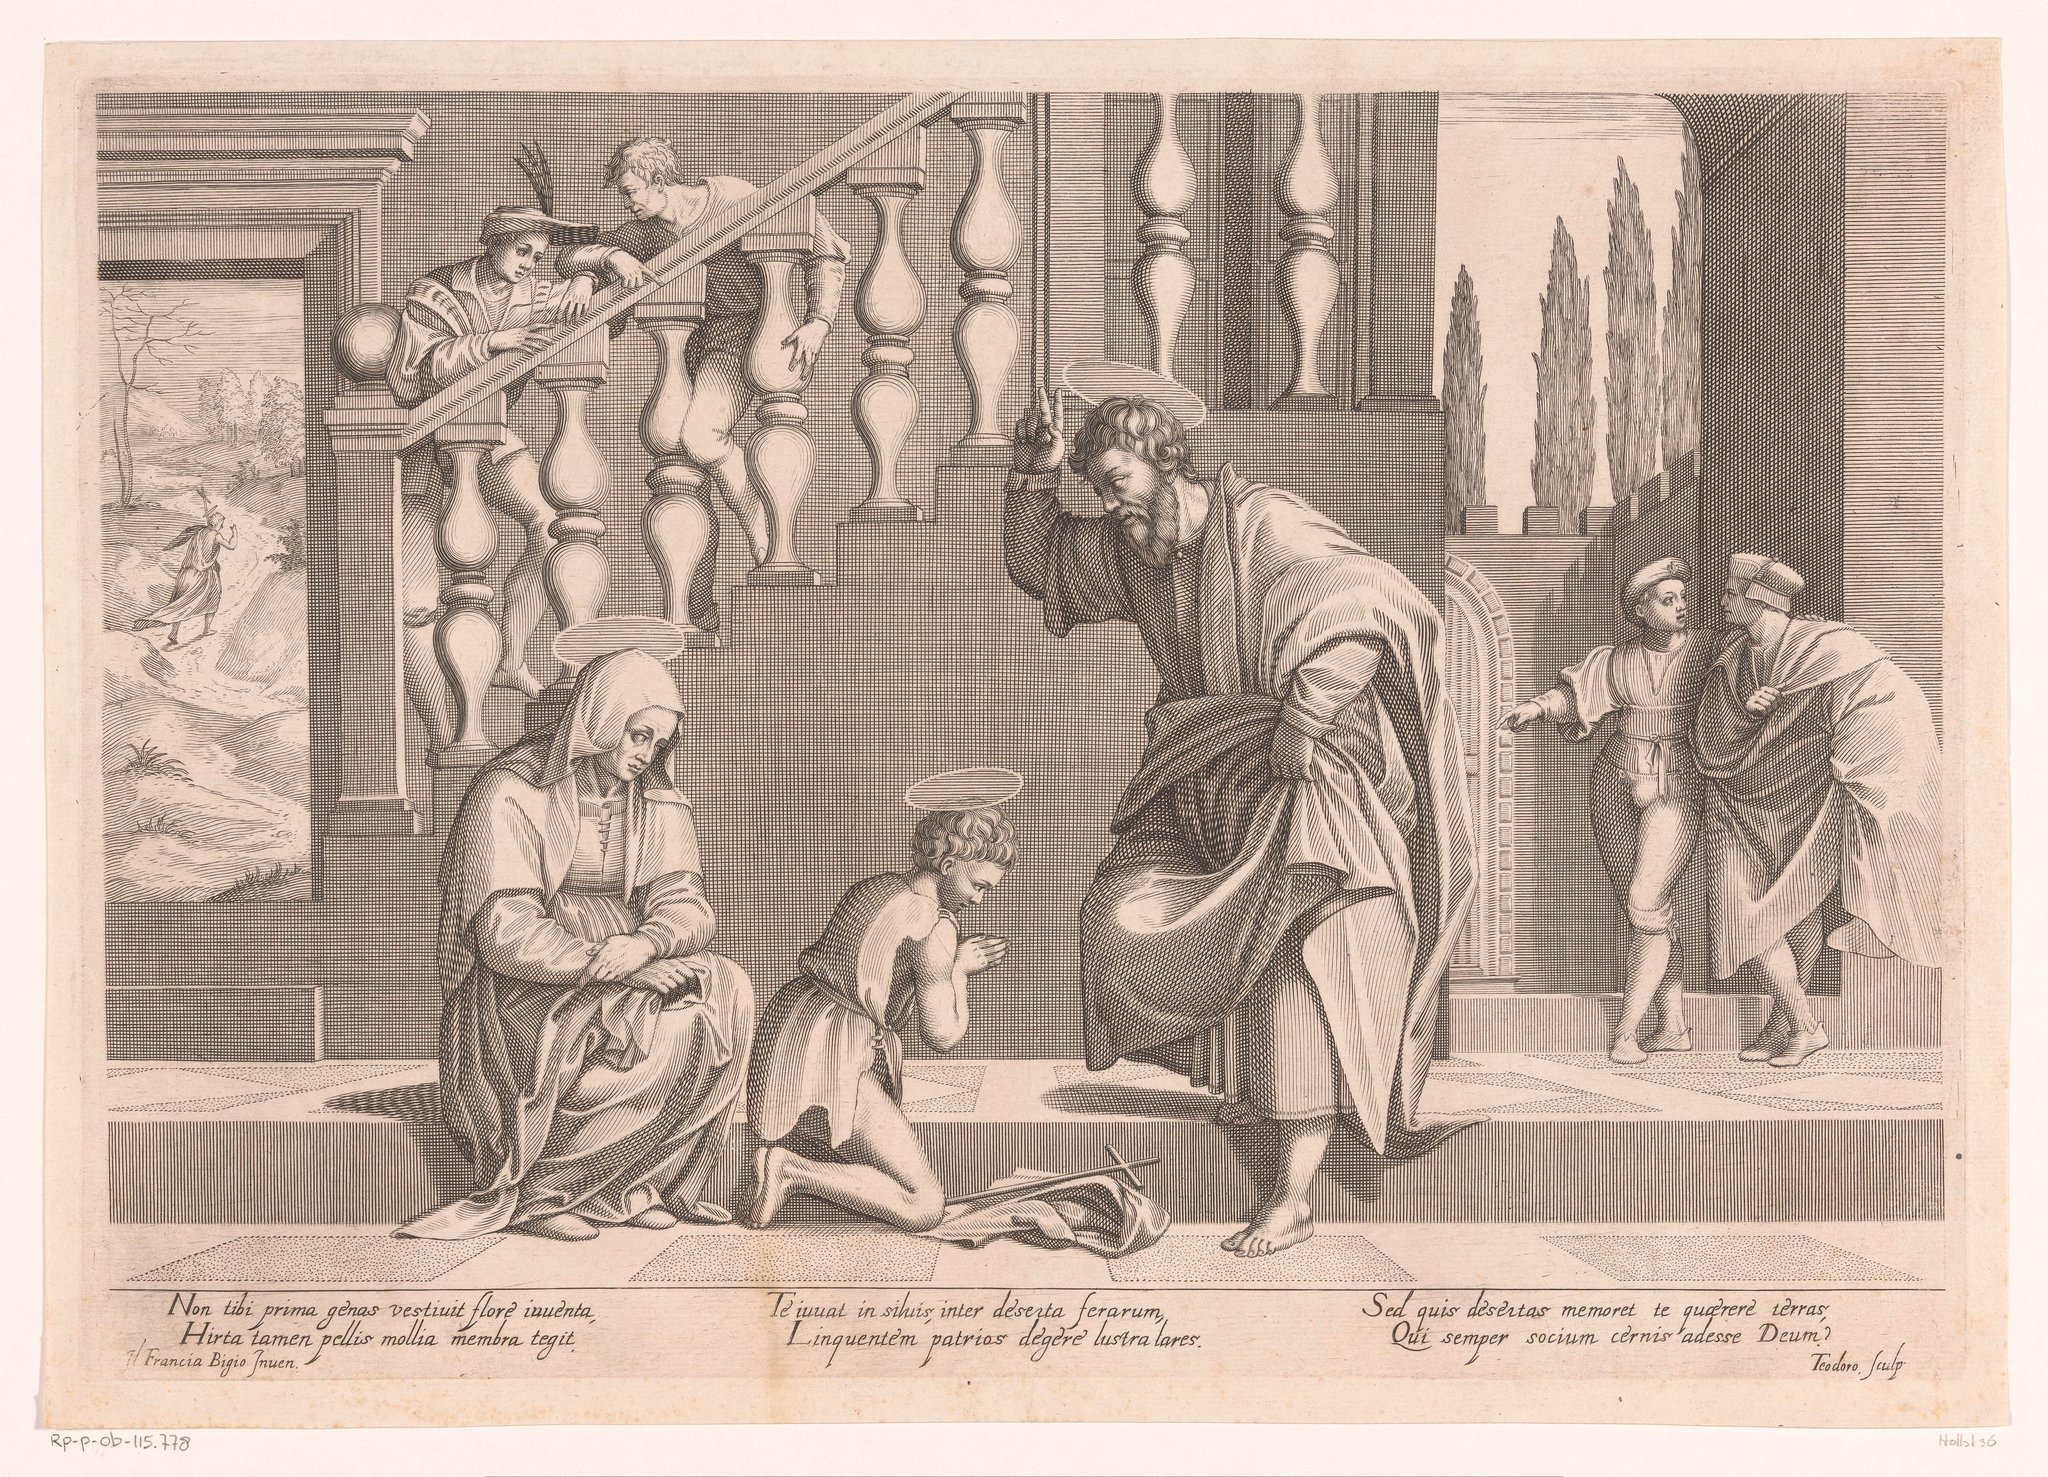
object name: print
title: Vita D. ioannis Baptistae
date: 1617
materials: paper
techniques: engraving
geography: venice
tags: john the baptist leaves his parents to go into the wilderness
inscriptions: collector's mark: Lugt 240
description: Onderdeel van een serie van dertien prenten en een titelprent.